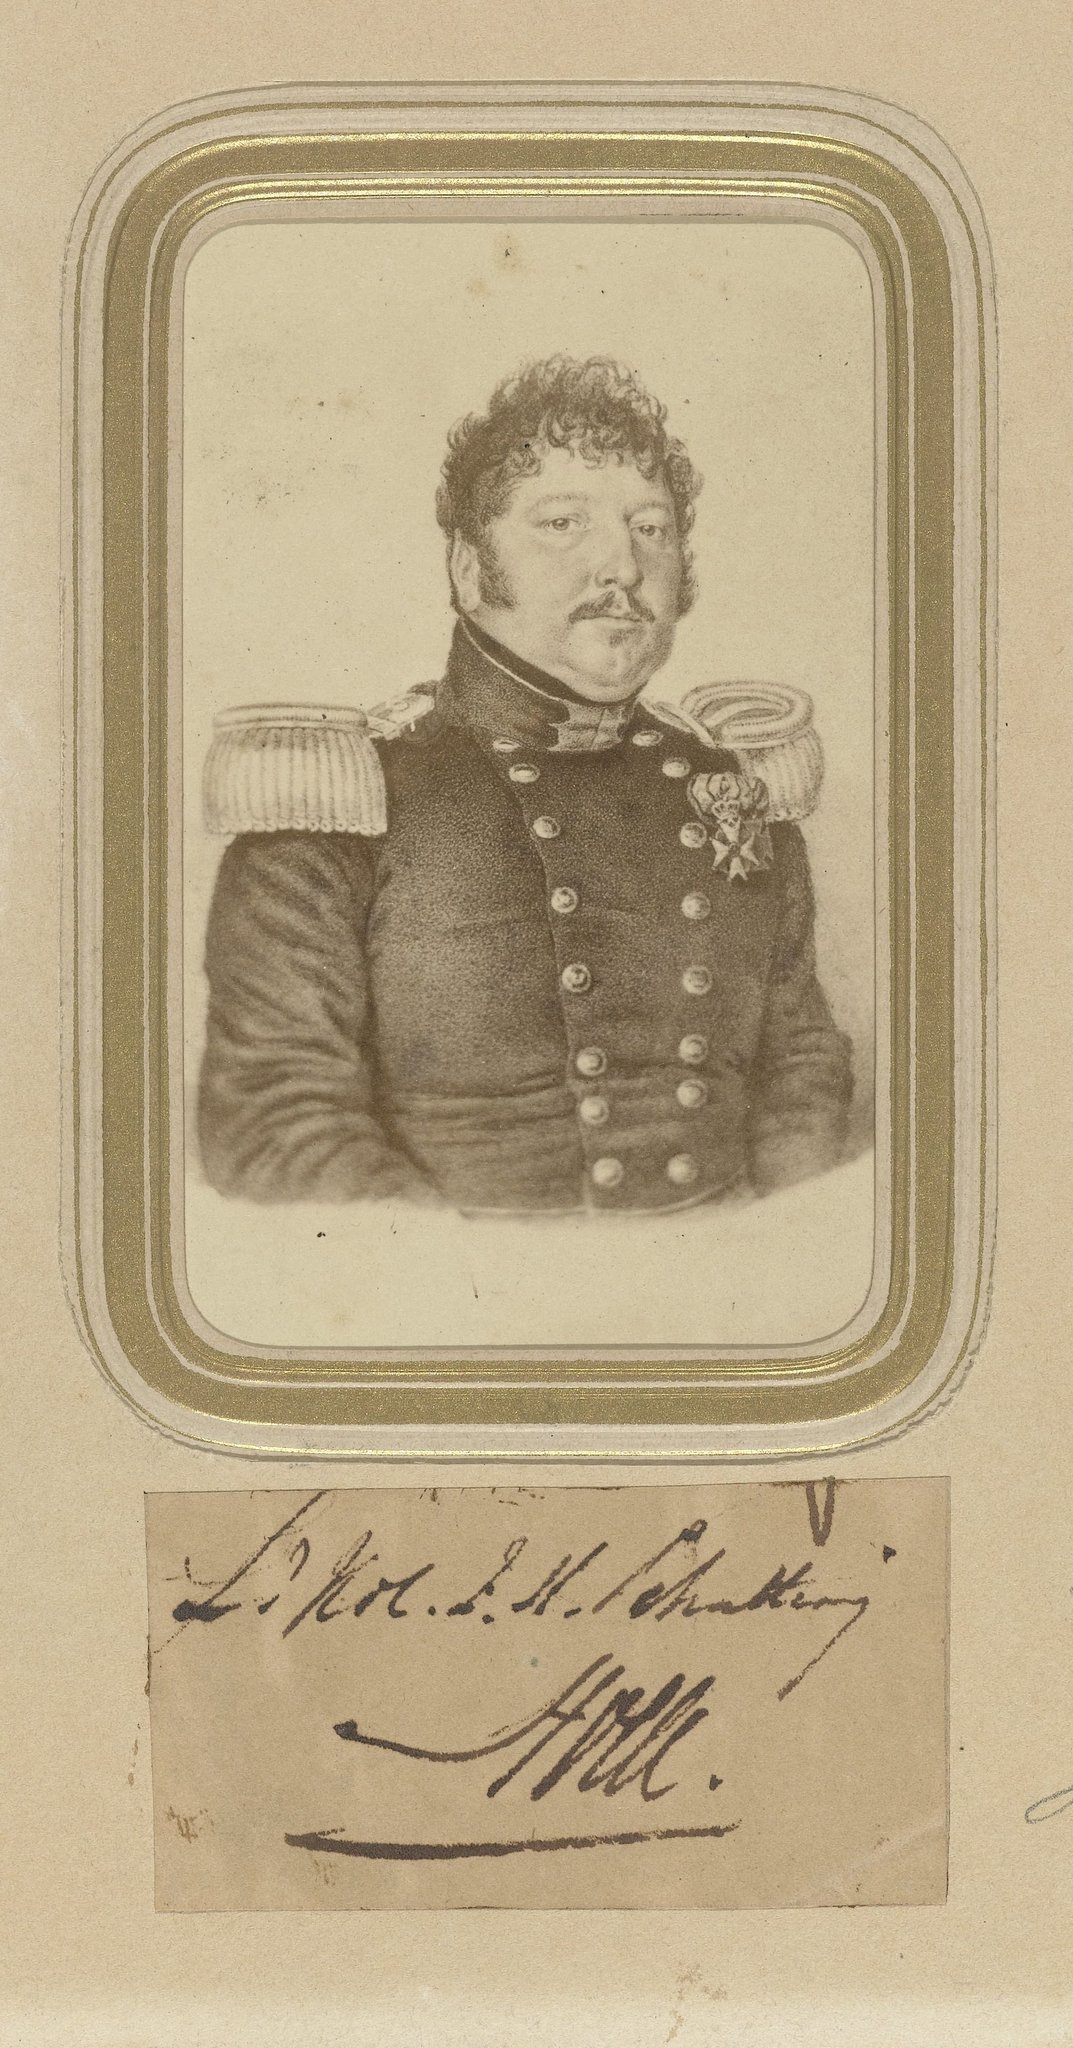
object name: photograph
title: J.H. Holle, Luitenant-Kolonel bij de Zuid-Hollandse Schutterij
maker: kornelis willem schorteldoek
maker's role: boekbinder, fotograaf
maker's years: 1800-1885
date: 1840-1922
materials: paper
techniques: photography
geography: gorinchem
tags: oostkapelle, luitenant-kolonel, johannes hermanus holle